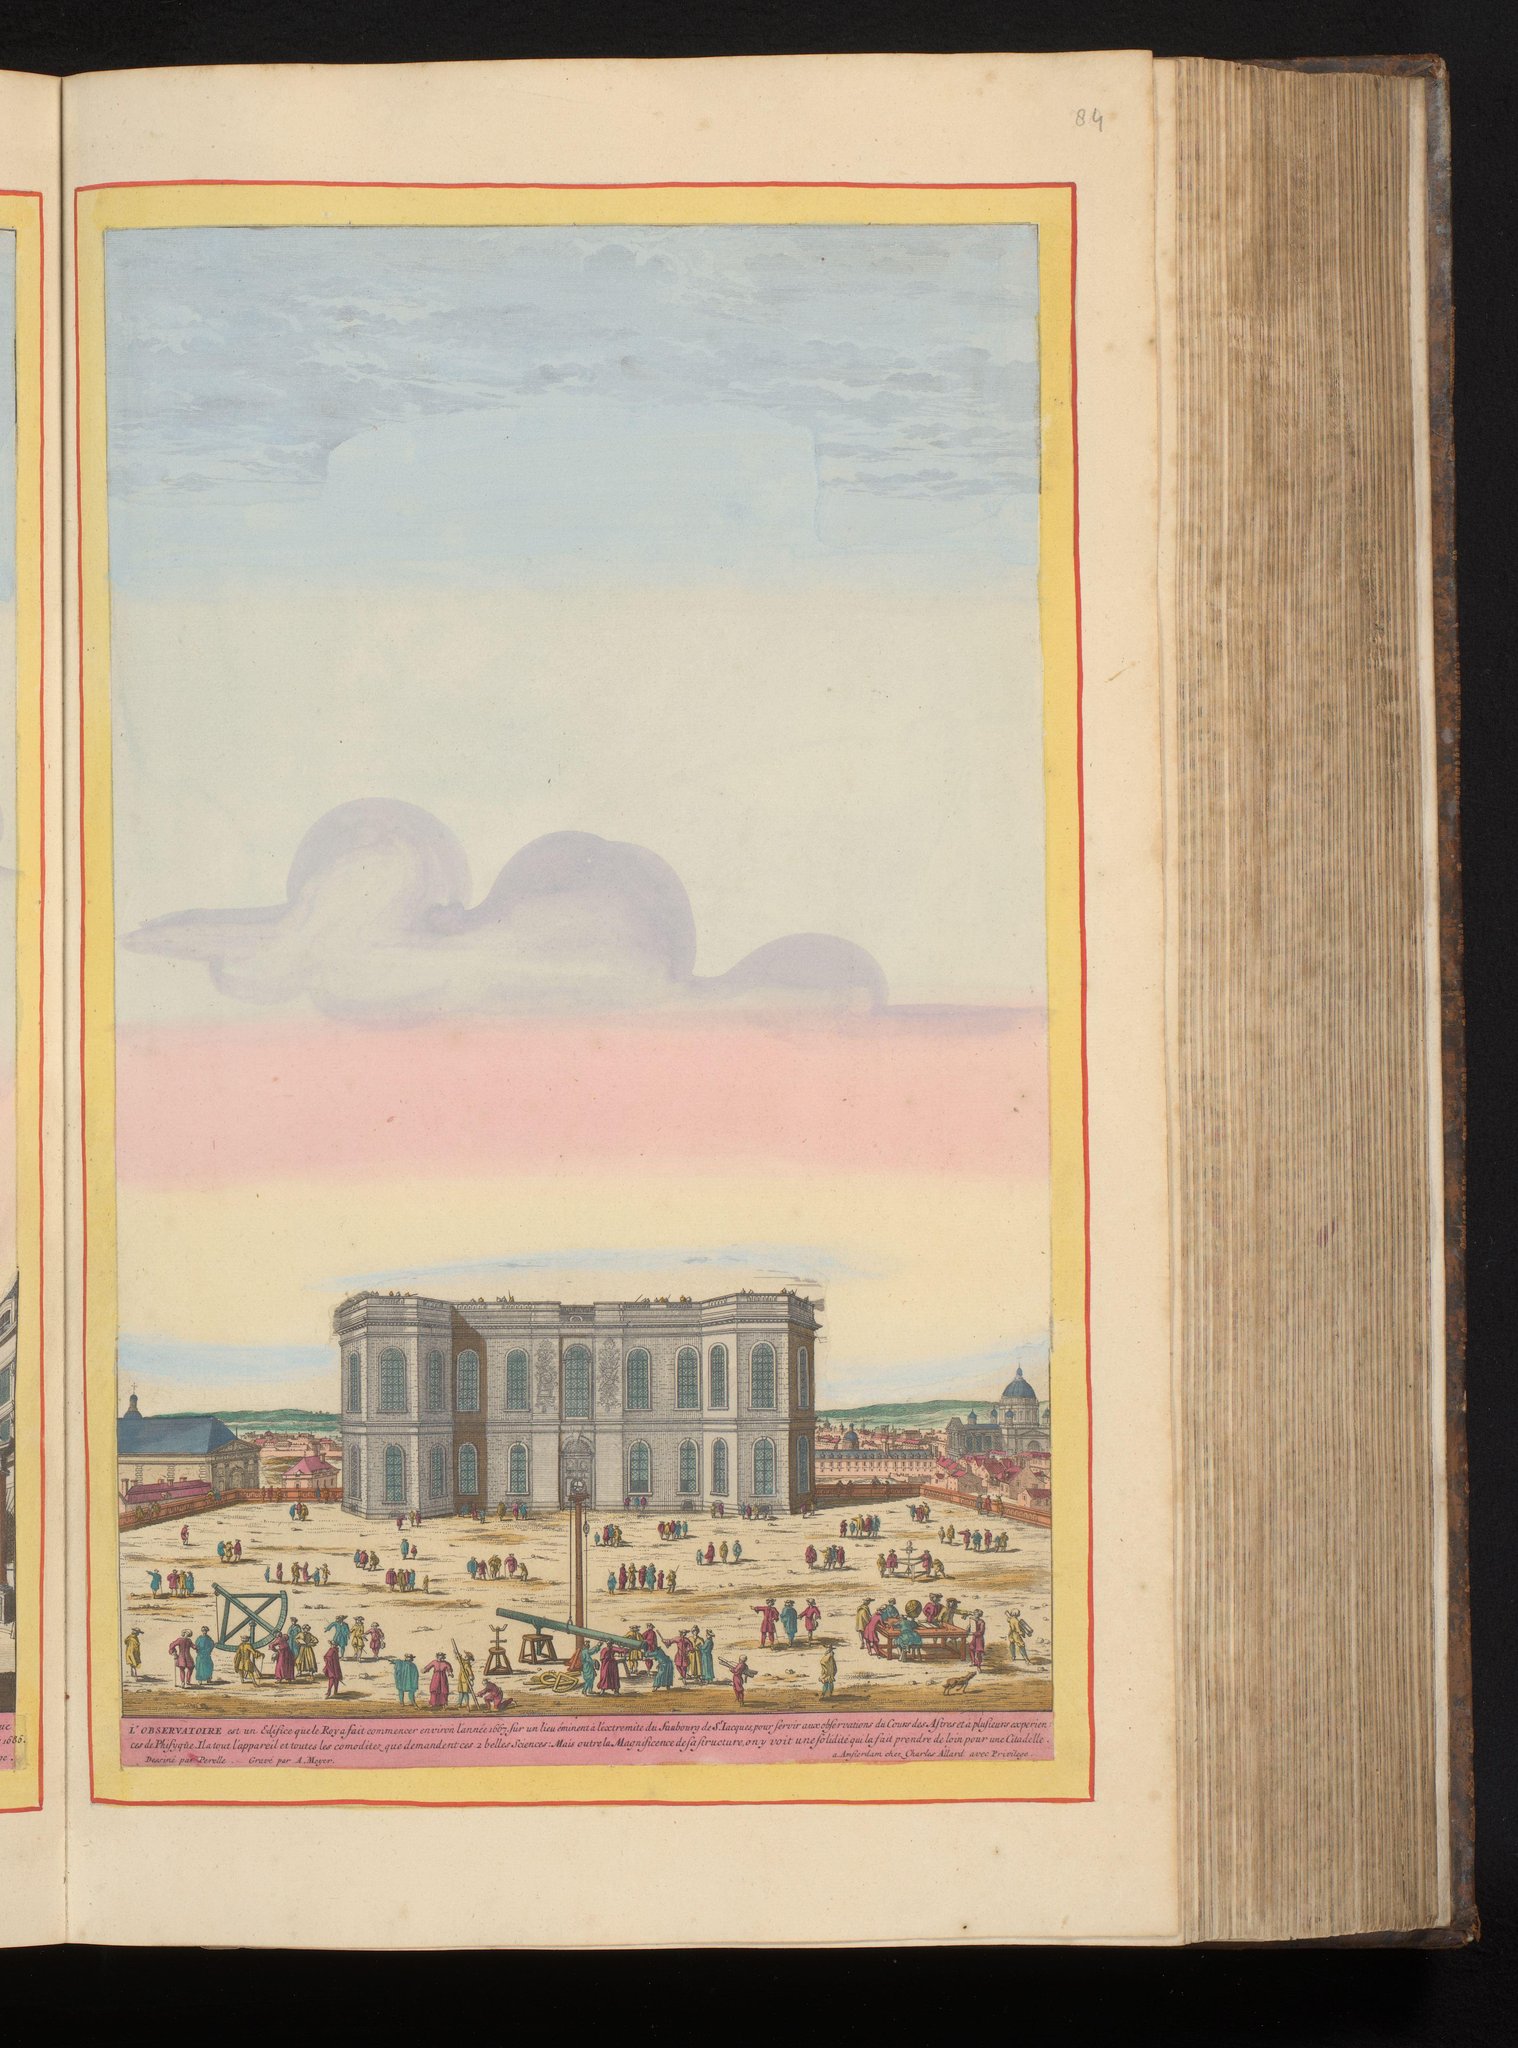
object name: print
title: Gezicht op het Observatoire te Parijs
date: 1685-1695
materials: paper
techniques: engraving, etching, hand coloring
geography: amsterdam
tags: observatory (~ astronomy)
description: De prent is langs de bovenrand van de voorstelling afgescheurd. Het bovenste gedeelte is hoger opgeplakt, zodat de lucht hoger is geworden en het formaat van de voorstelling past bij de andere groot formaatvoorstellingen in het album.